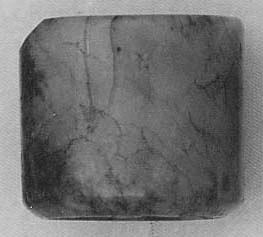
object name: thumb ring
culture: chinese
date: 206 BCE-220 CE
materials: jade